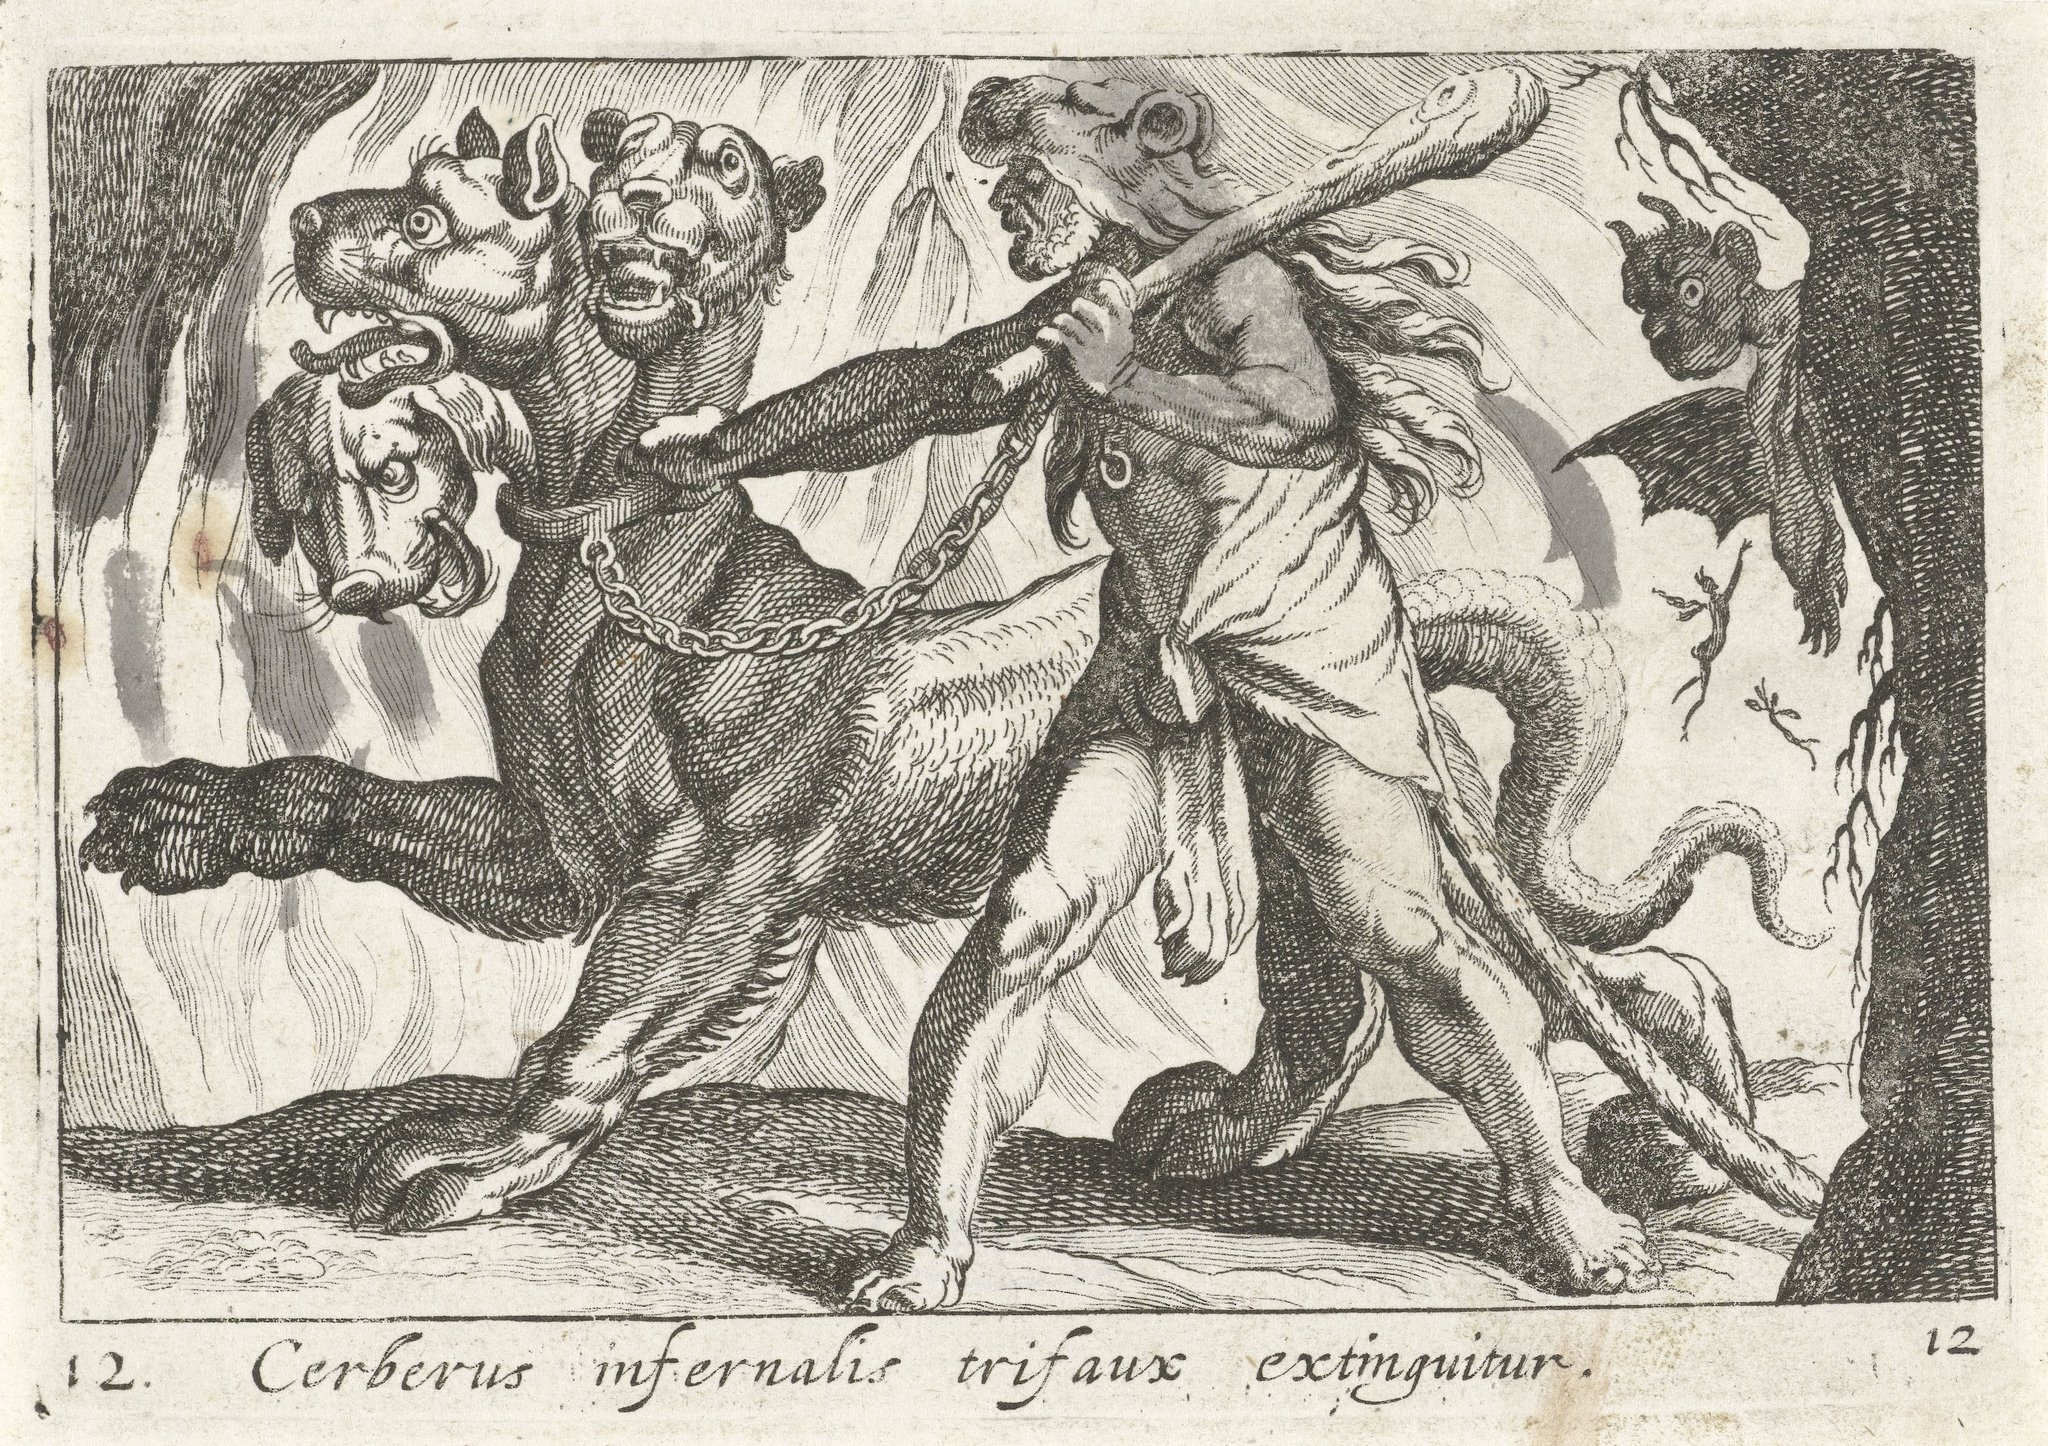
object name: print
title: Cerberus infernalis trifaux extinguitur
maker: simon frisius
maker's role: print maker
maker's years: 1570-1628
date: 1610-1664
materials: paper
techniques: etching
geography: northern netherlands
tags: (12) cerberus captured and carried away by hercules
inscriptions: collector's mark: Lugt 2228